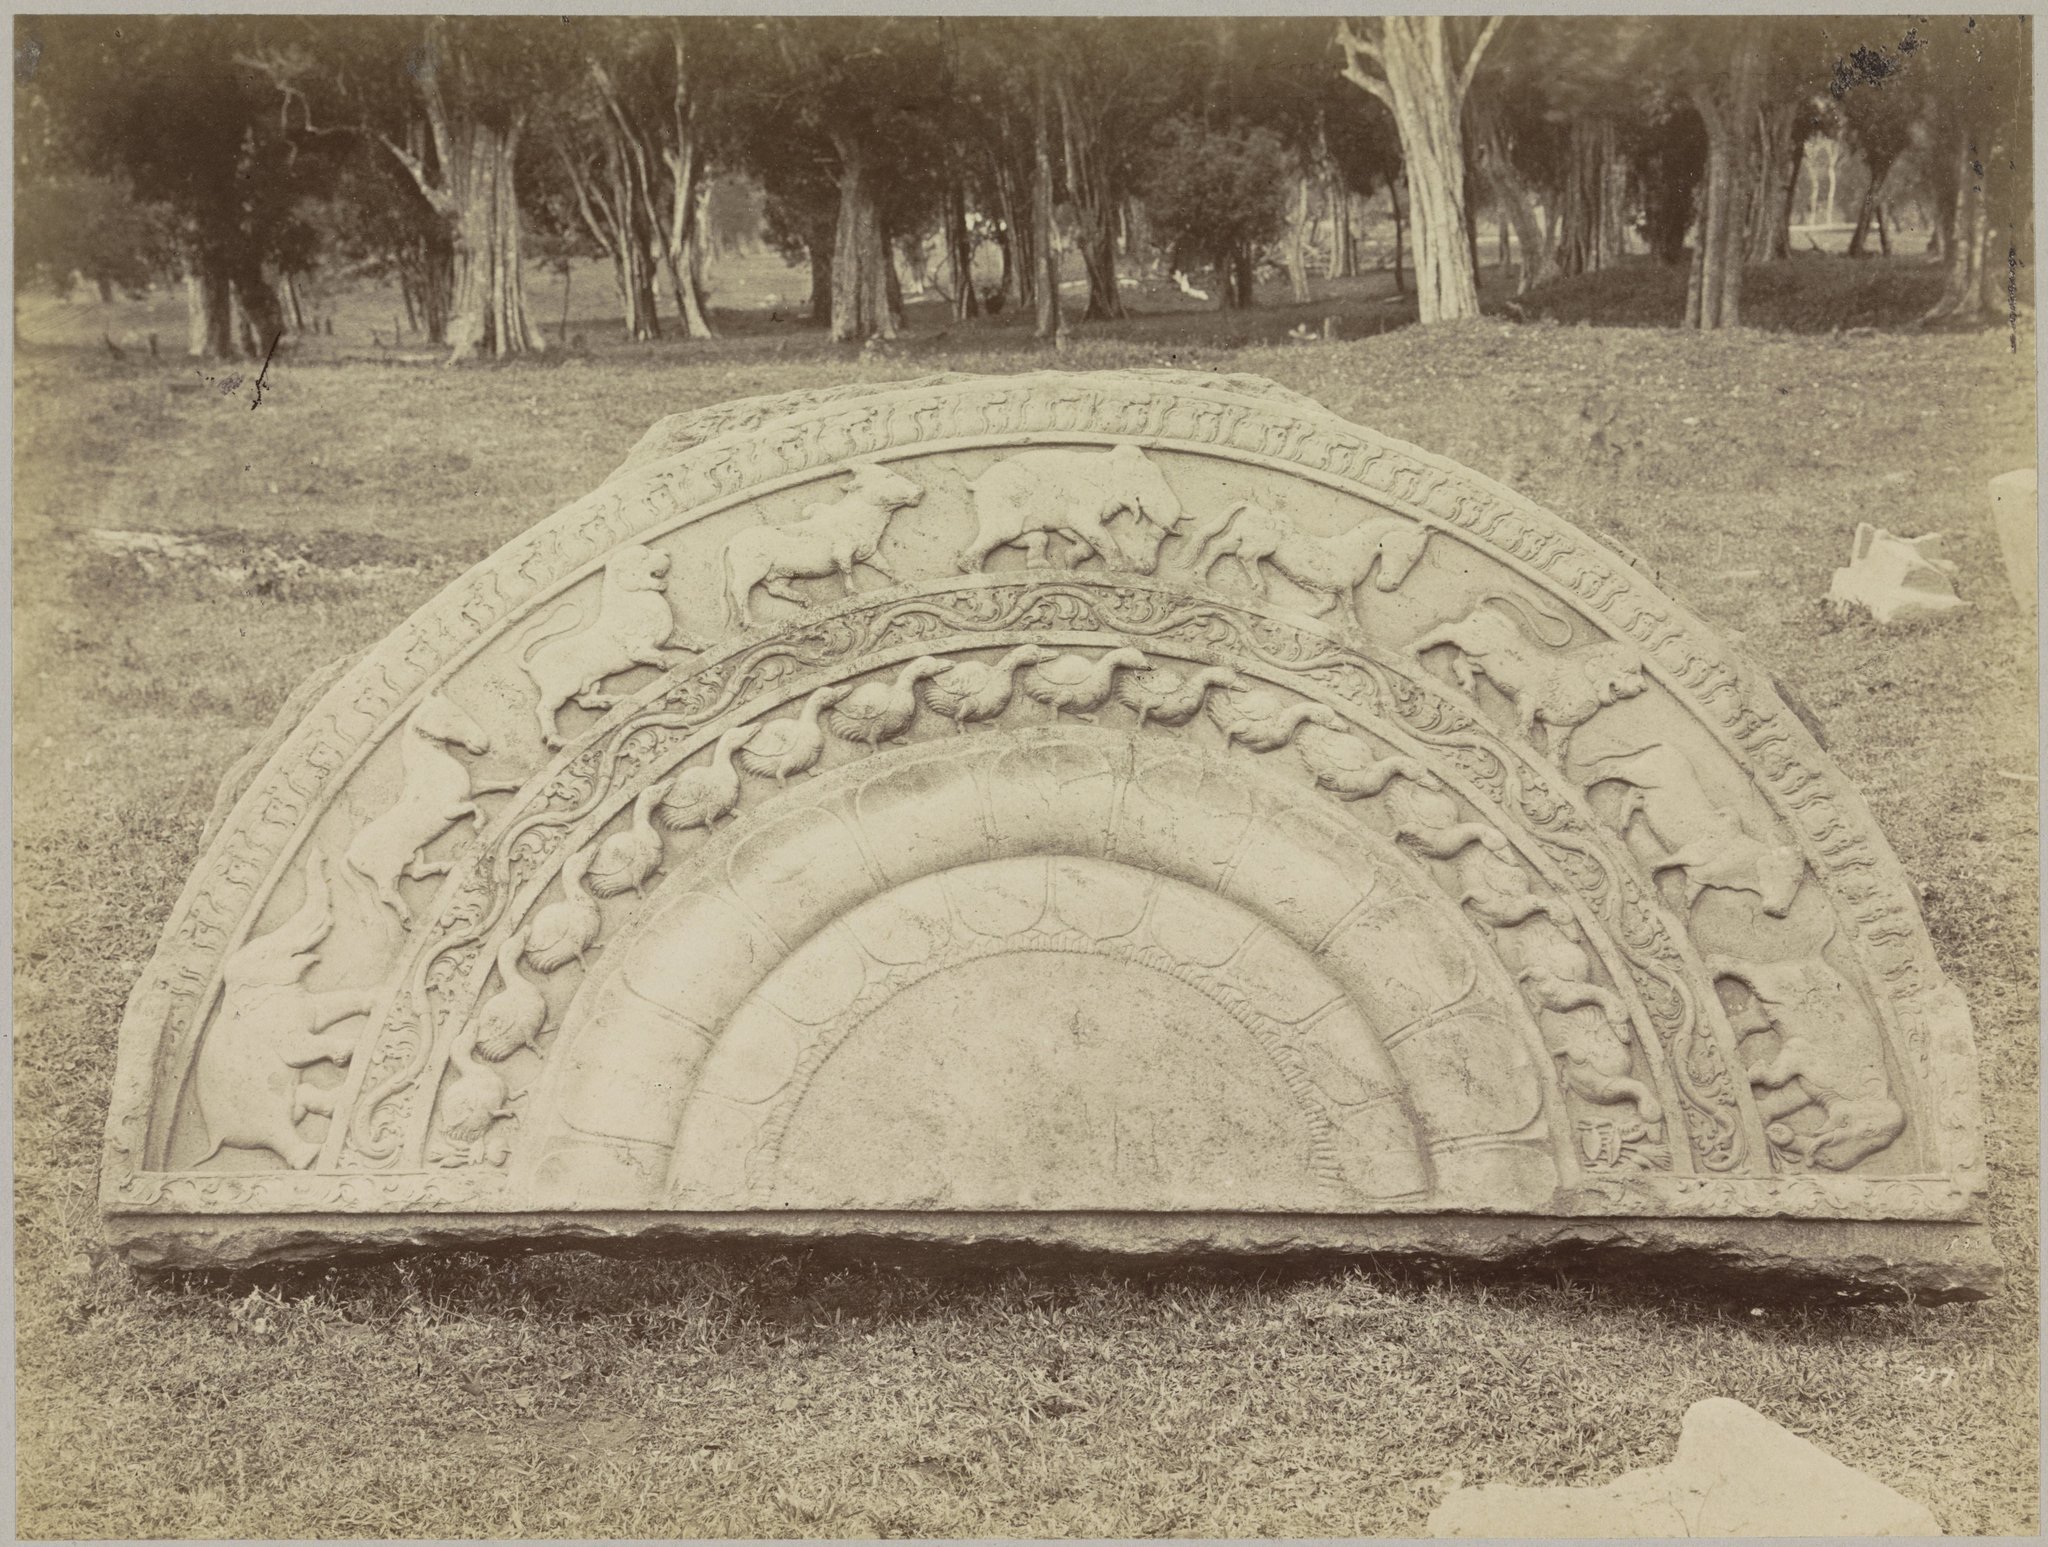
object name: photograph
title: Moonstone, Anuradhapura, Sri Lanka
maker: Anonymous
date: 1895-1915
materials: cardboard, paper, photographic support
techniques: albumen print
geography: anuradhapura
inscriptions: inscription: ‘11. Moonstone.’, number: ‘217’